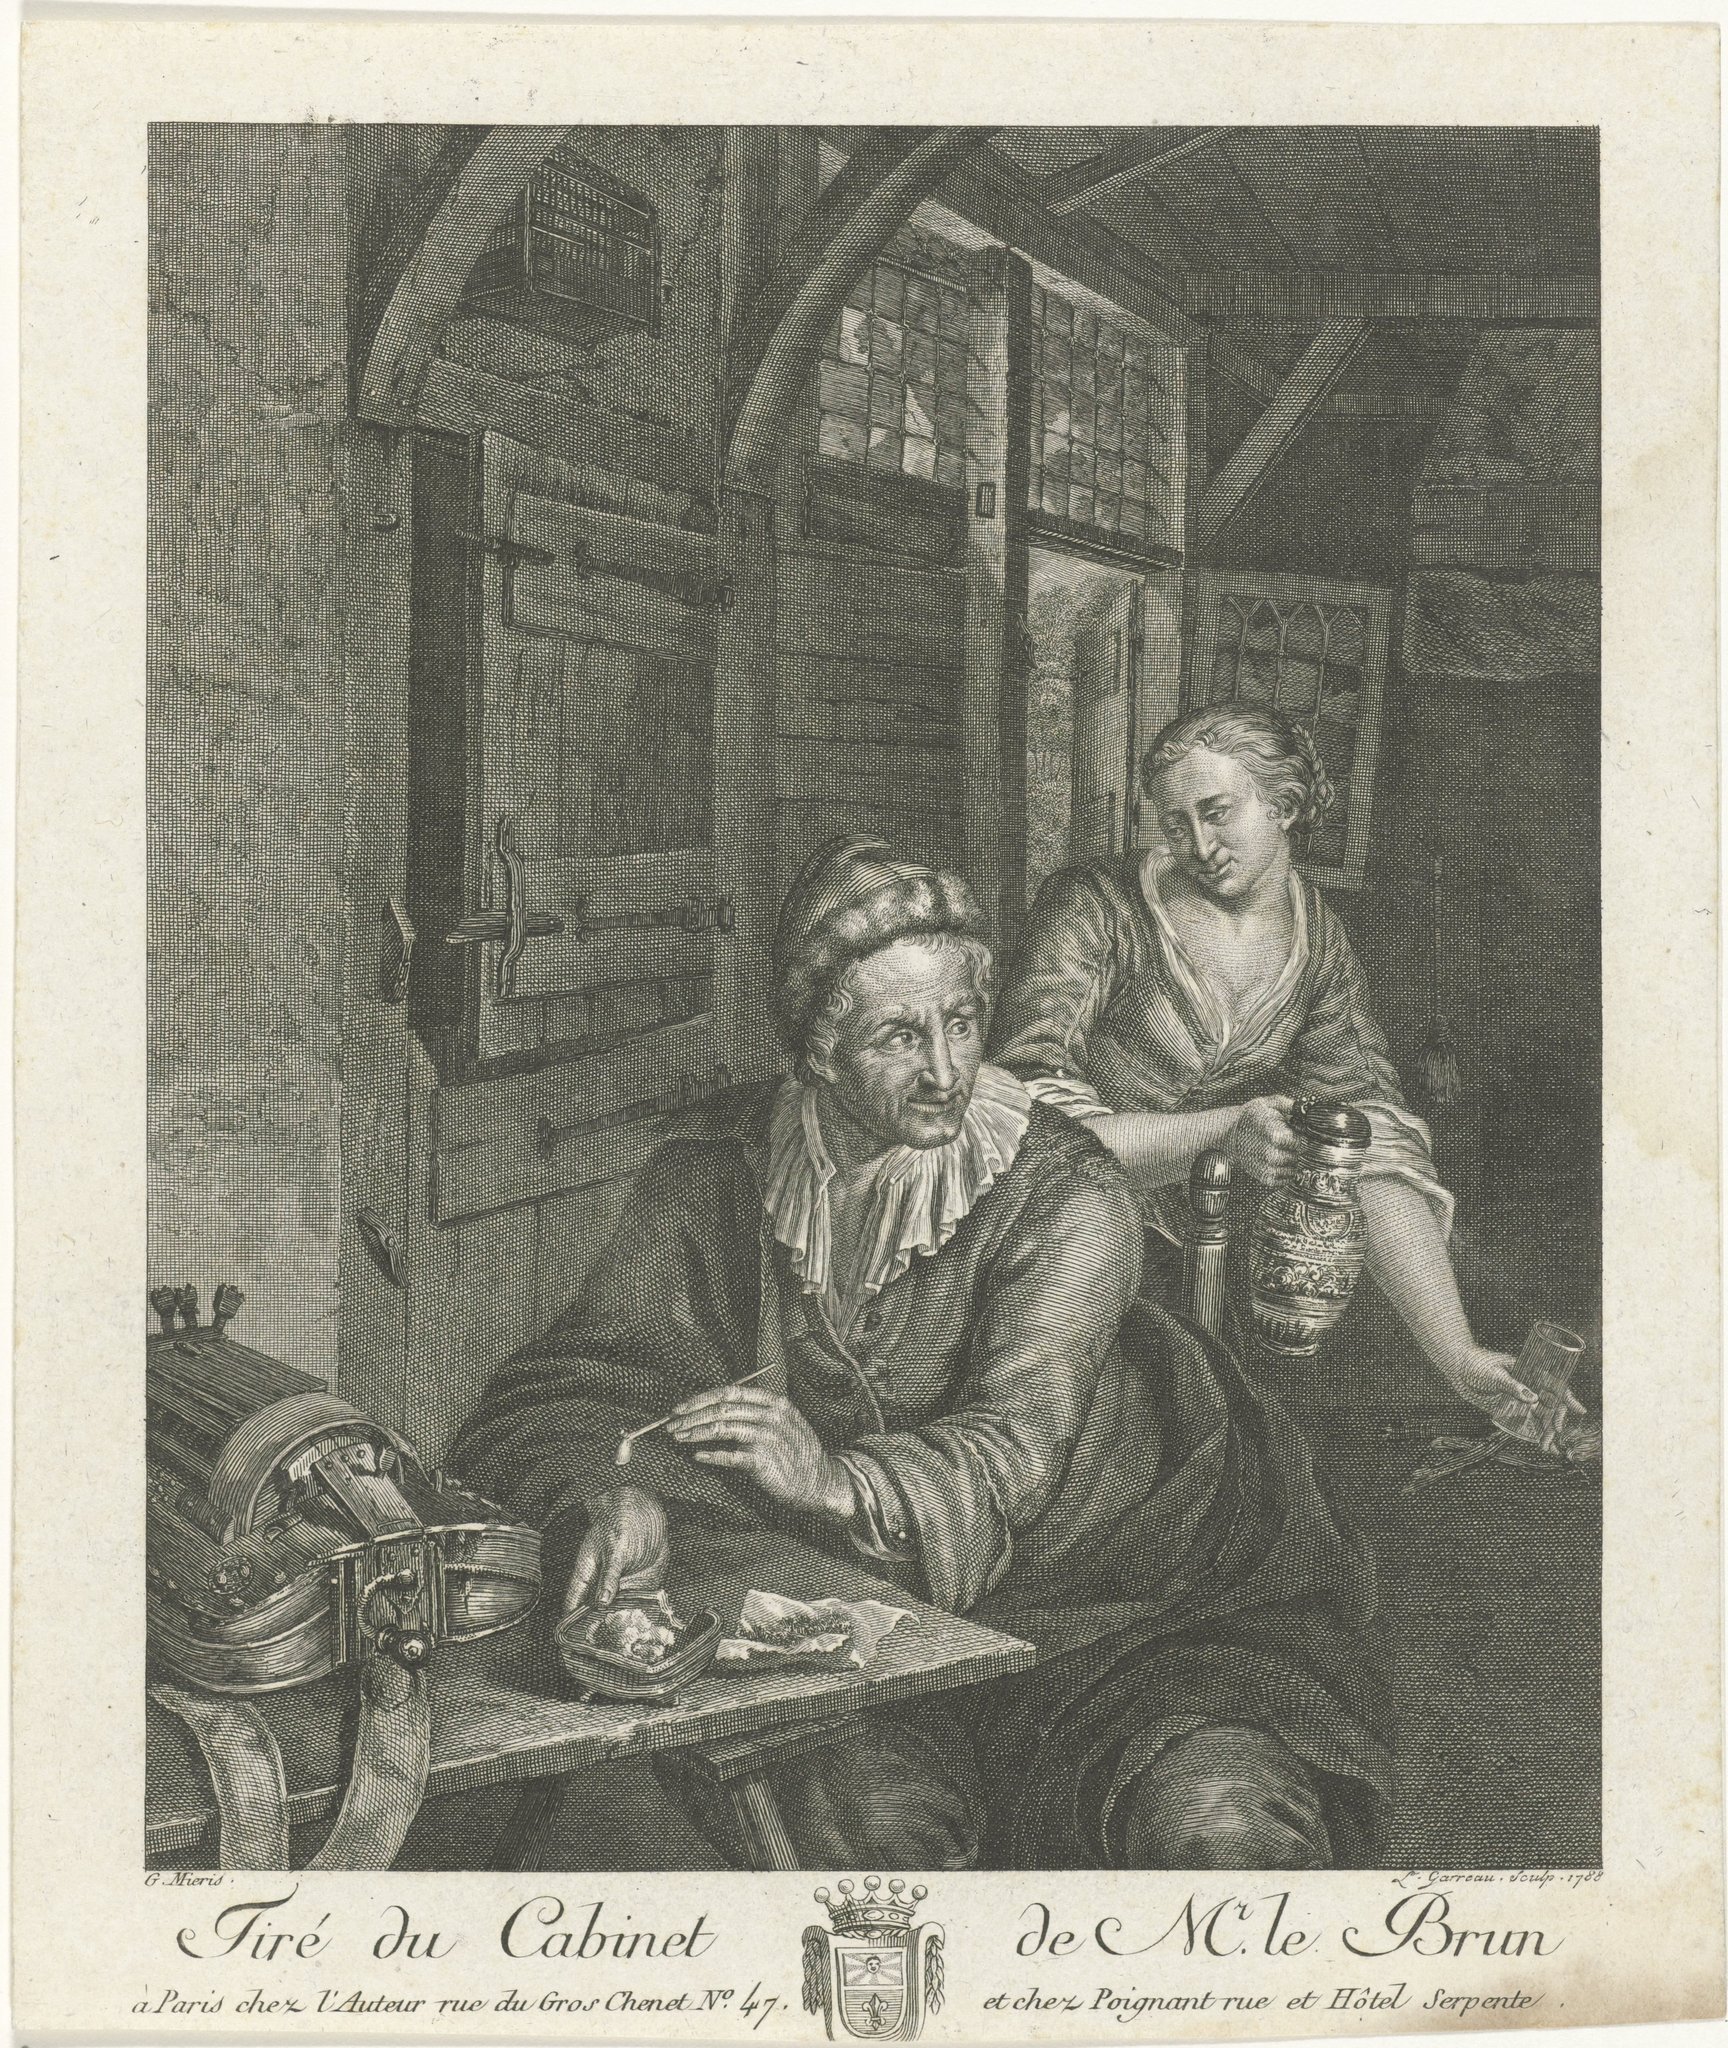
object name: print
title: Lierdraaier in een herberg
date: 1788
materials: paper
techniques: engraving, etching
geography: paris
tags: hurdy-gurdy, pipe ~ tobacco, maid ~ house personnel, musician in non-work situation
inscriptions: collector's mark: Lugt 2228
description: Een lierdraaier zit in een herberg zijn pijp op te steken. Achter hem staat een meid met kan en glas. Op de tafel een draailier. De prent is naar een schilderij van Willem van Mieris en is deel van een serie van prenten naar Vlaamse, Duitse en Nederlandse schilders.